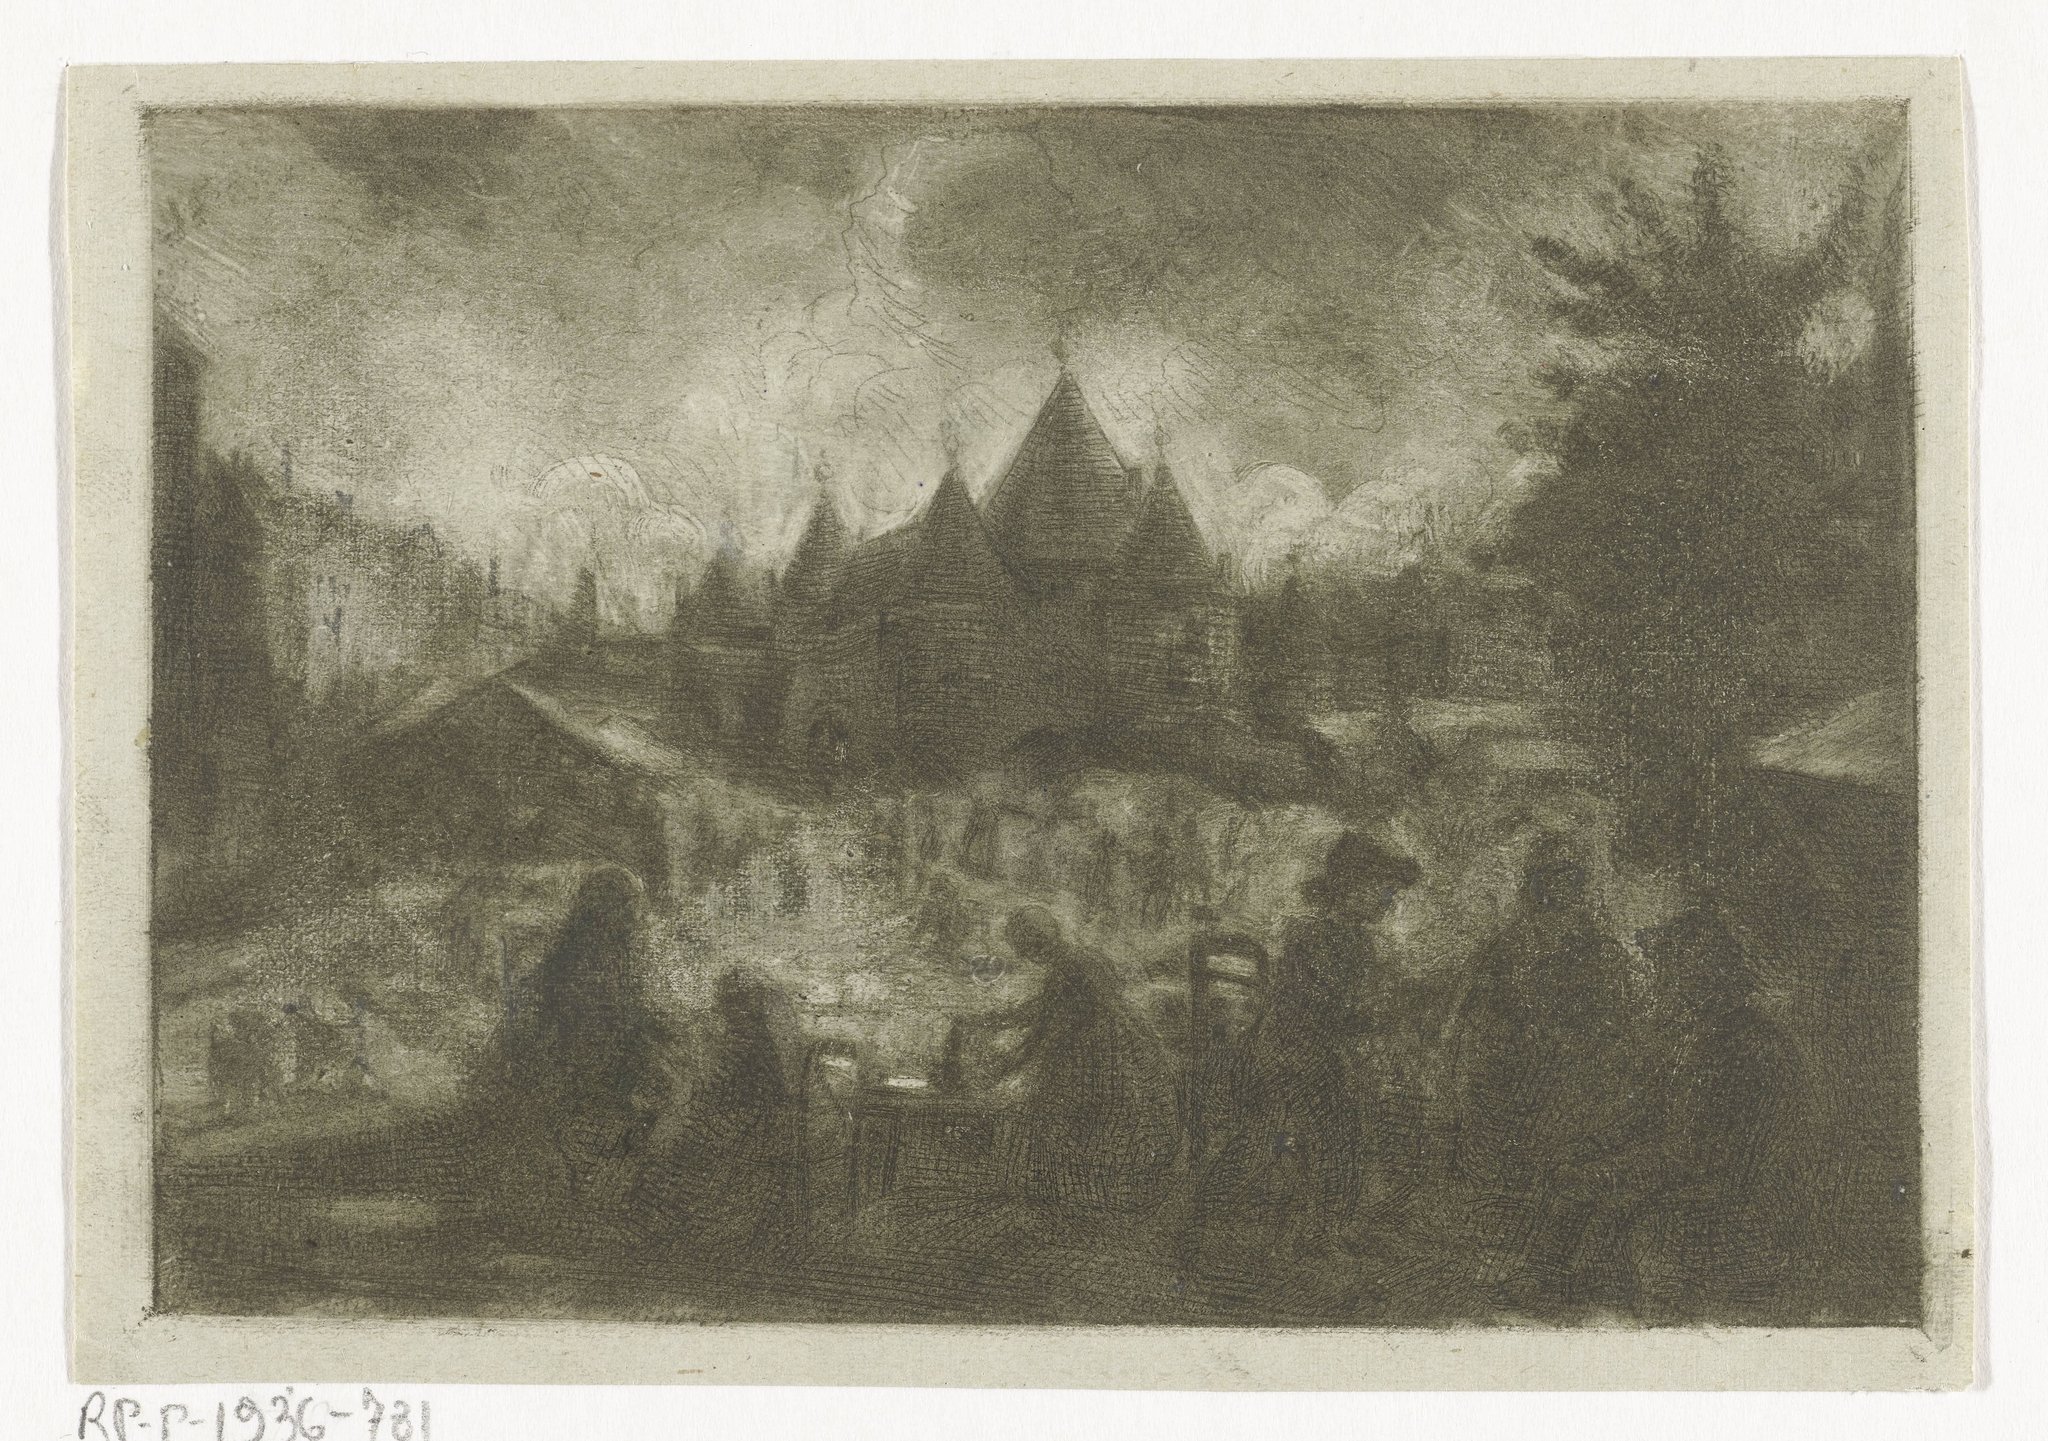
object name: print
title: Marktgezicht bij avond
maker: karel alexander august jan boom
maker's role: print maker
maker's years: 1862-1943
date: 1872-1936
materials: chalk, paper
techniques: etching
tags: urban life, castle, pavement, terrace in front of inn or restaurant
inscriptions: collector's mark: Lugt 2228, collector's mark: Lugt 2760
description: Avond in een stad. Op de voorgrond zitten enkele mensen aan tafels te eten. Op de achtergrond een kasteel.